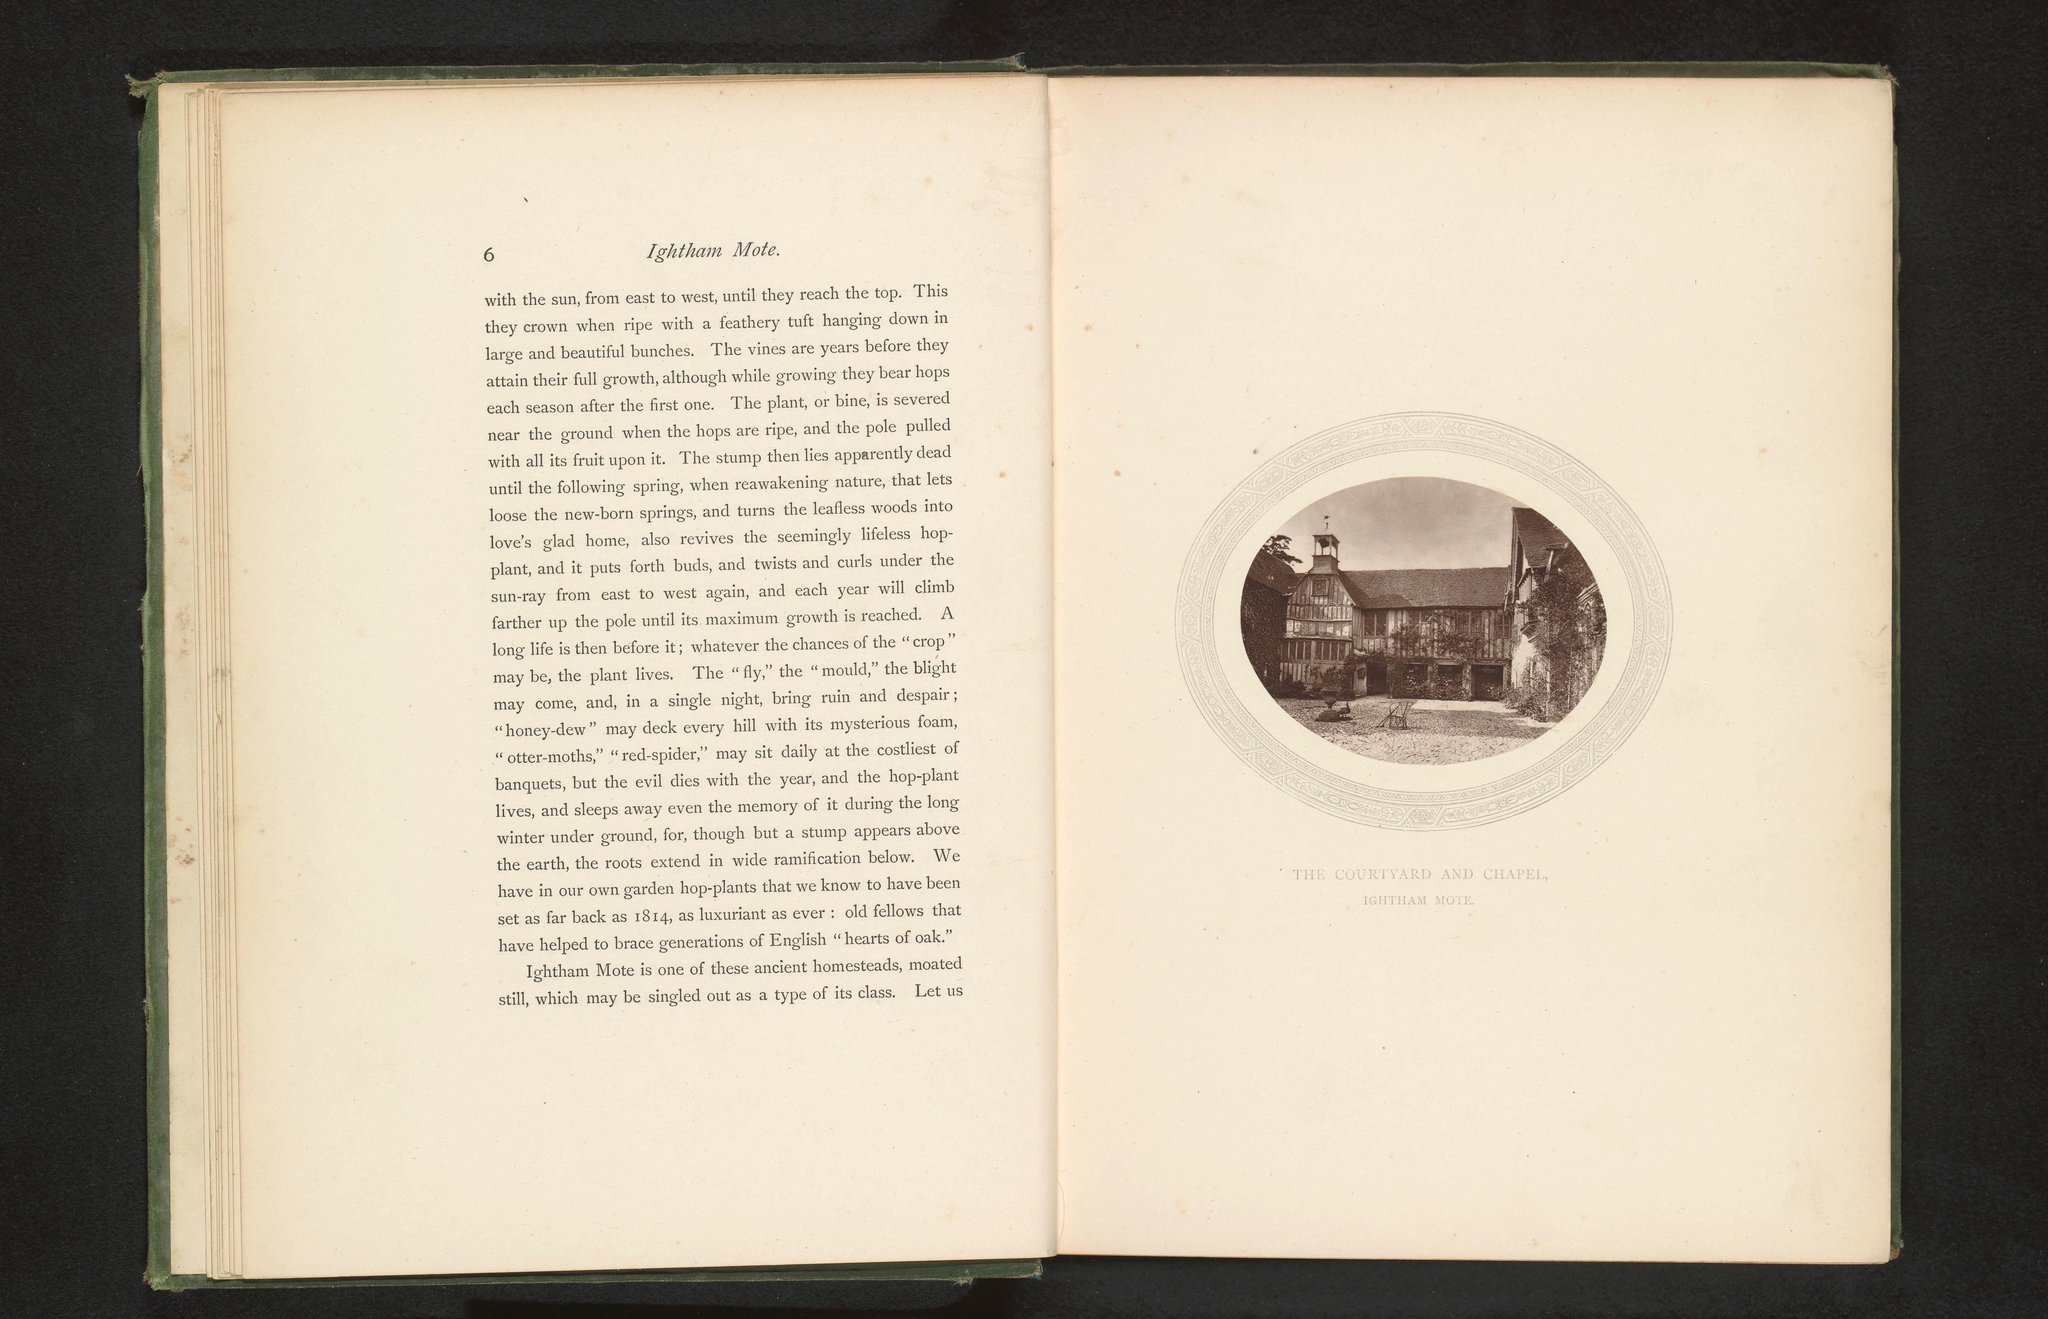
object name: photomechanical print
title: Binnenplaats en kapel van Ightham Mote vlakbij Ightham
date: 1866-1876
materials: paper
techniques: woodburytype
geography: ightham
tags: rural housing, e.g. country-house, villa, cottage, courtyard, church (exterior) - qq - small church, chapel